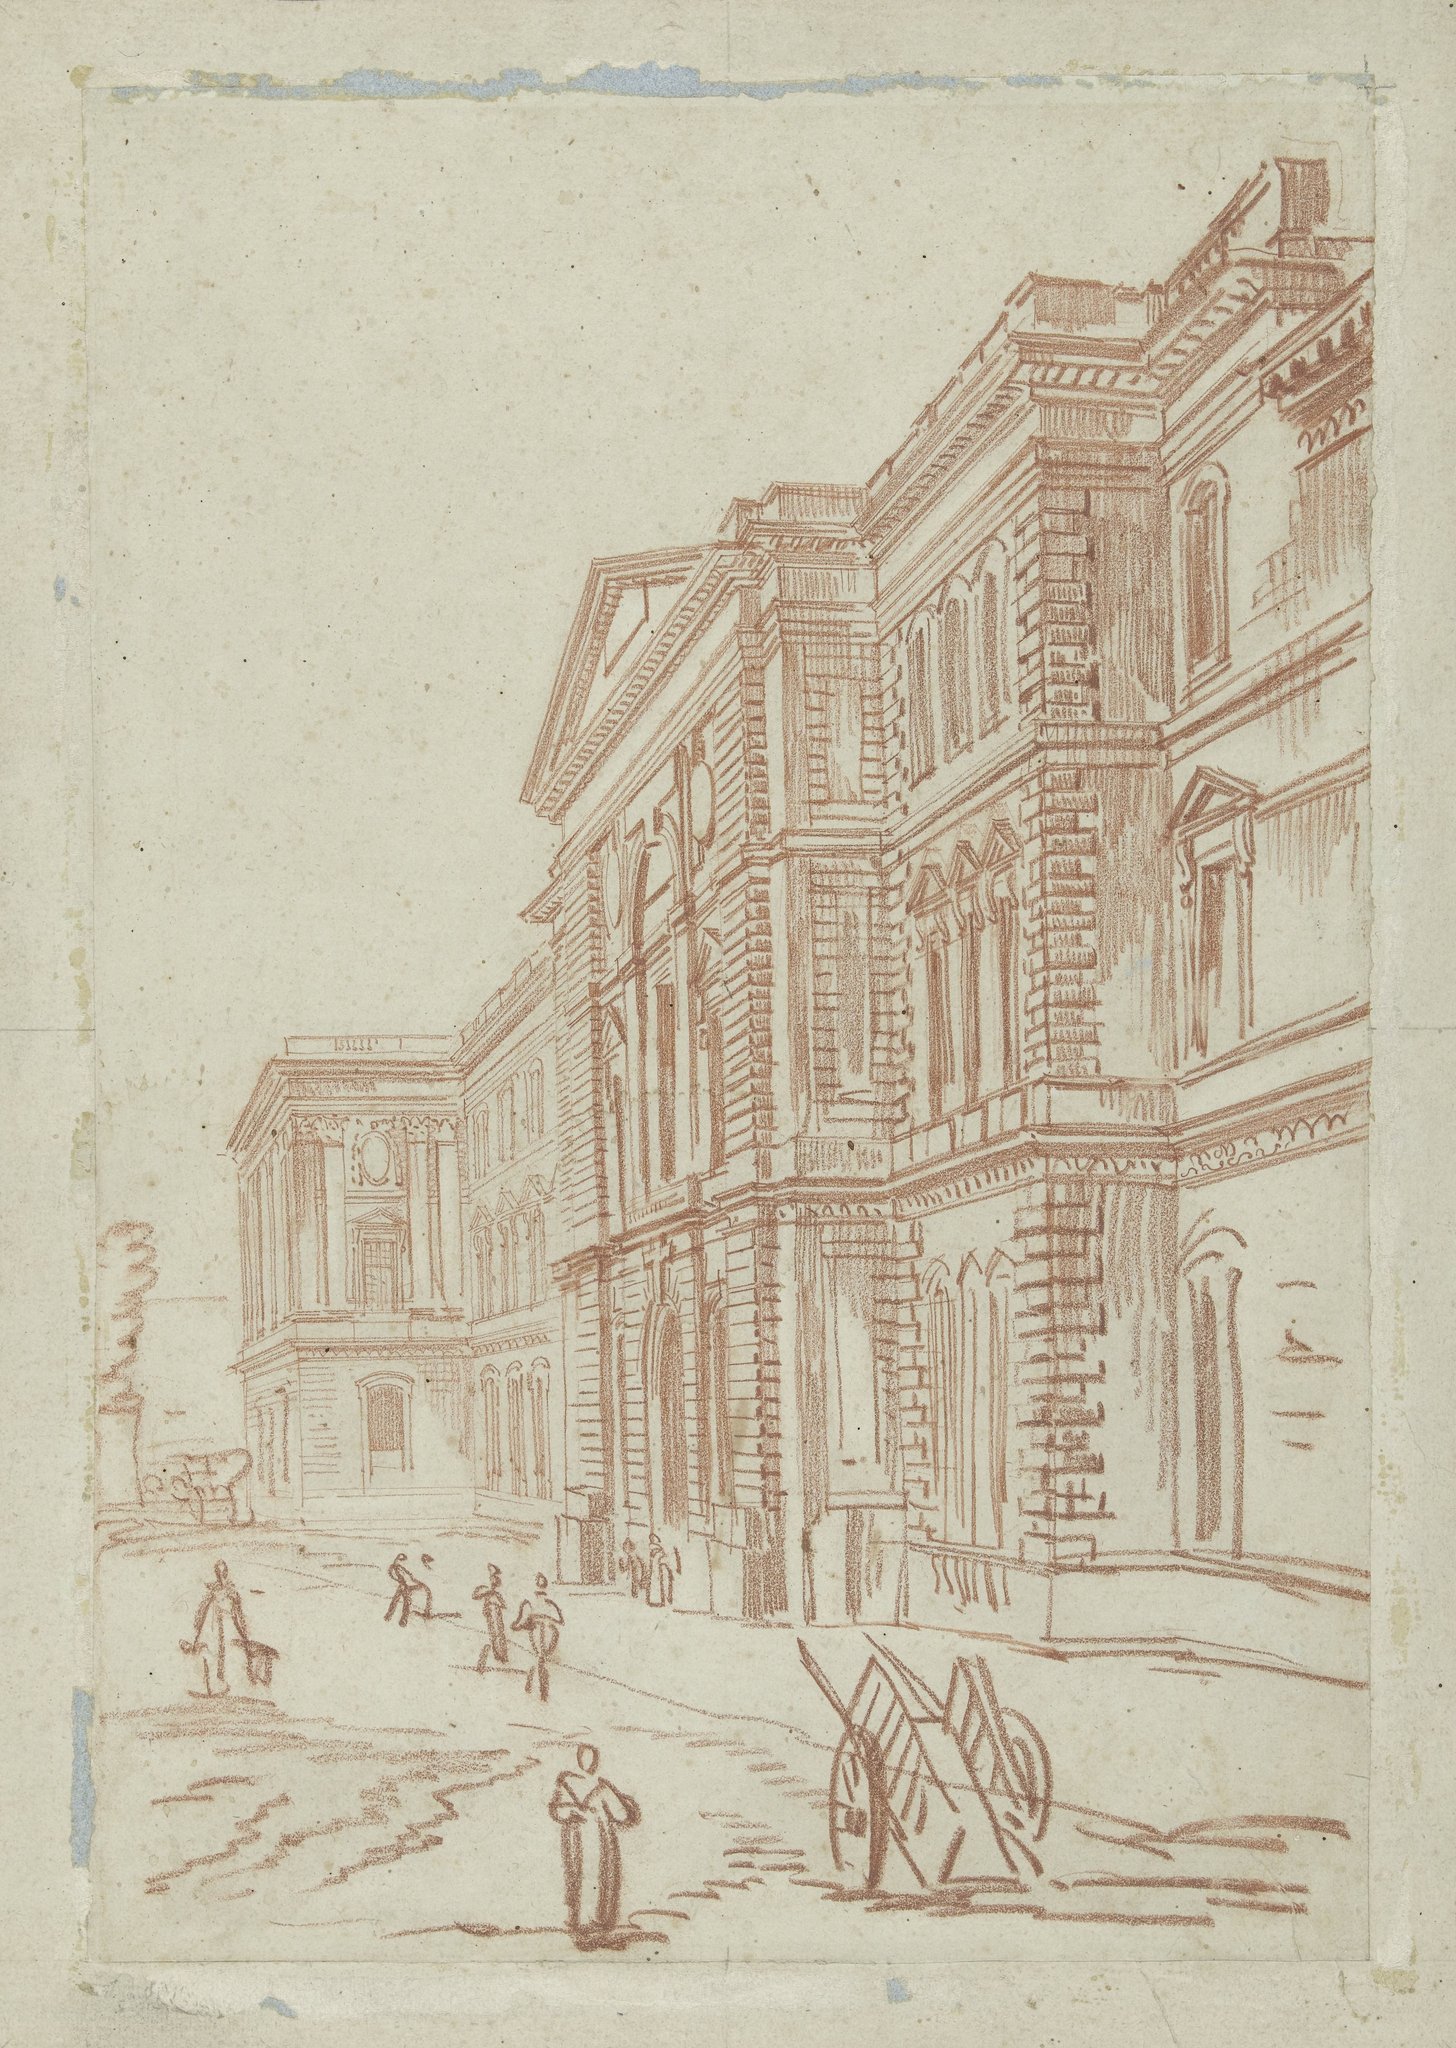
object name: drawing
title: Gedeelte van een gevel van het Louvre te Parijs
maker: hubert robert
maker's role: draughtsman, print maker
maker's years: 1733-1808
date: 1743-1808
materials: chalk, paper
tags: public road (+ city(-scape) with figures, staffage)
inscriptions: collector's mark: Lugt 2228